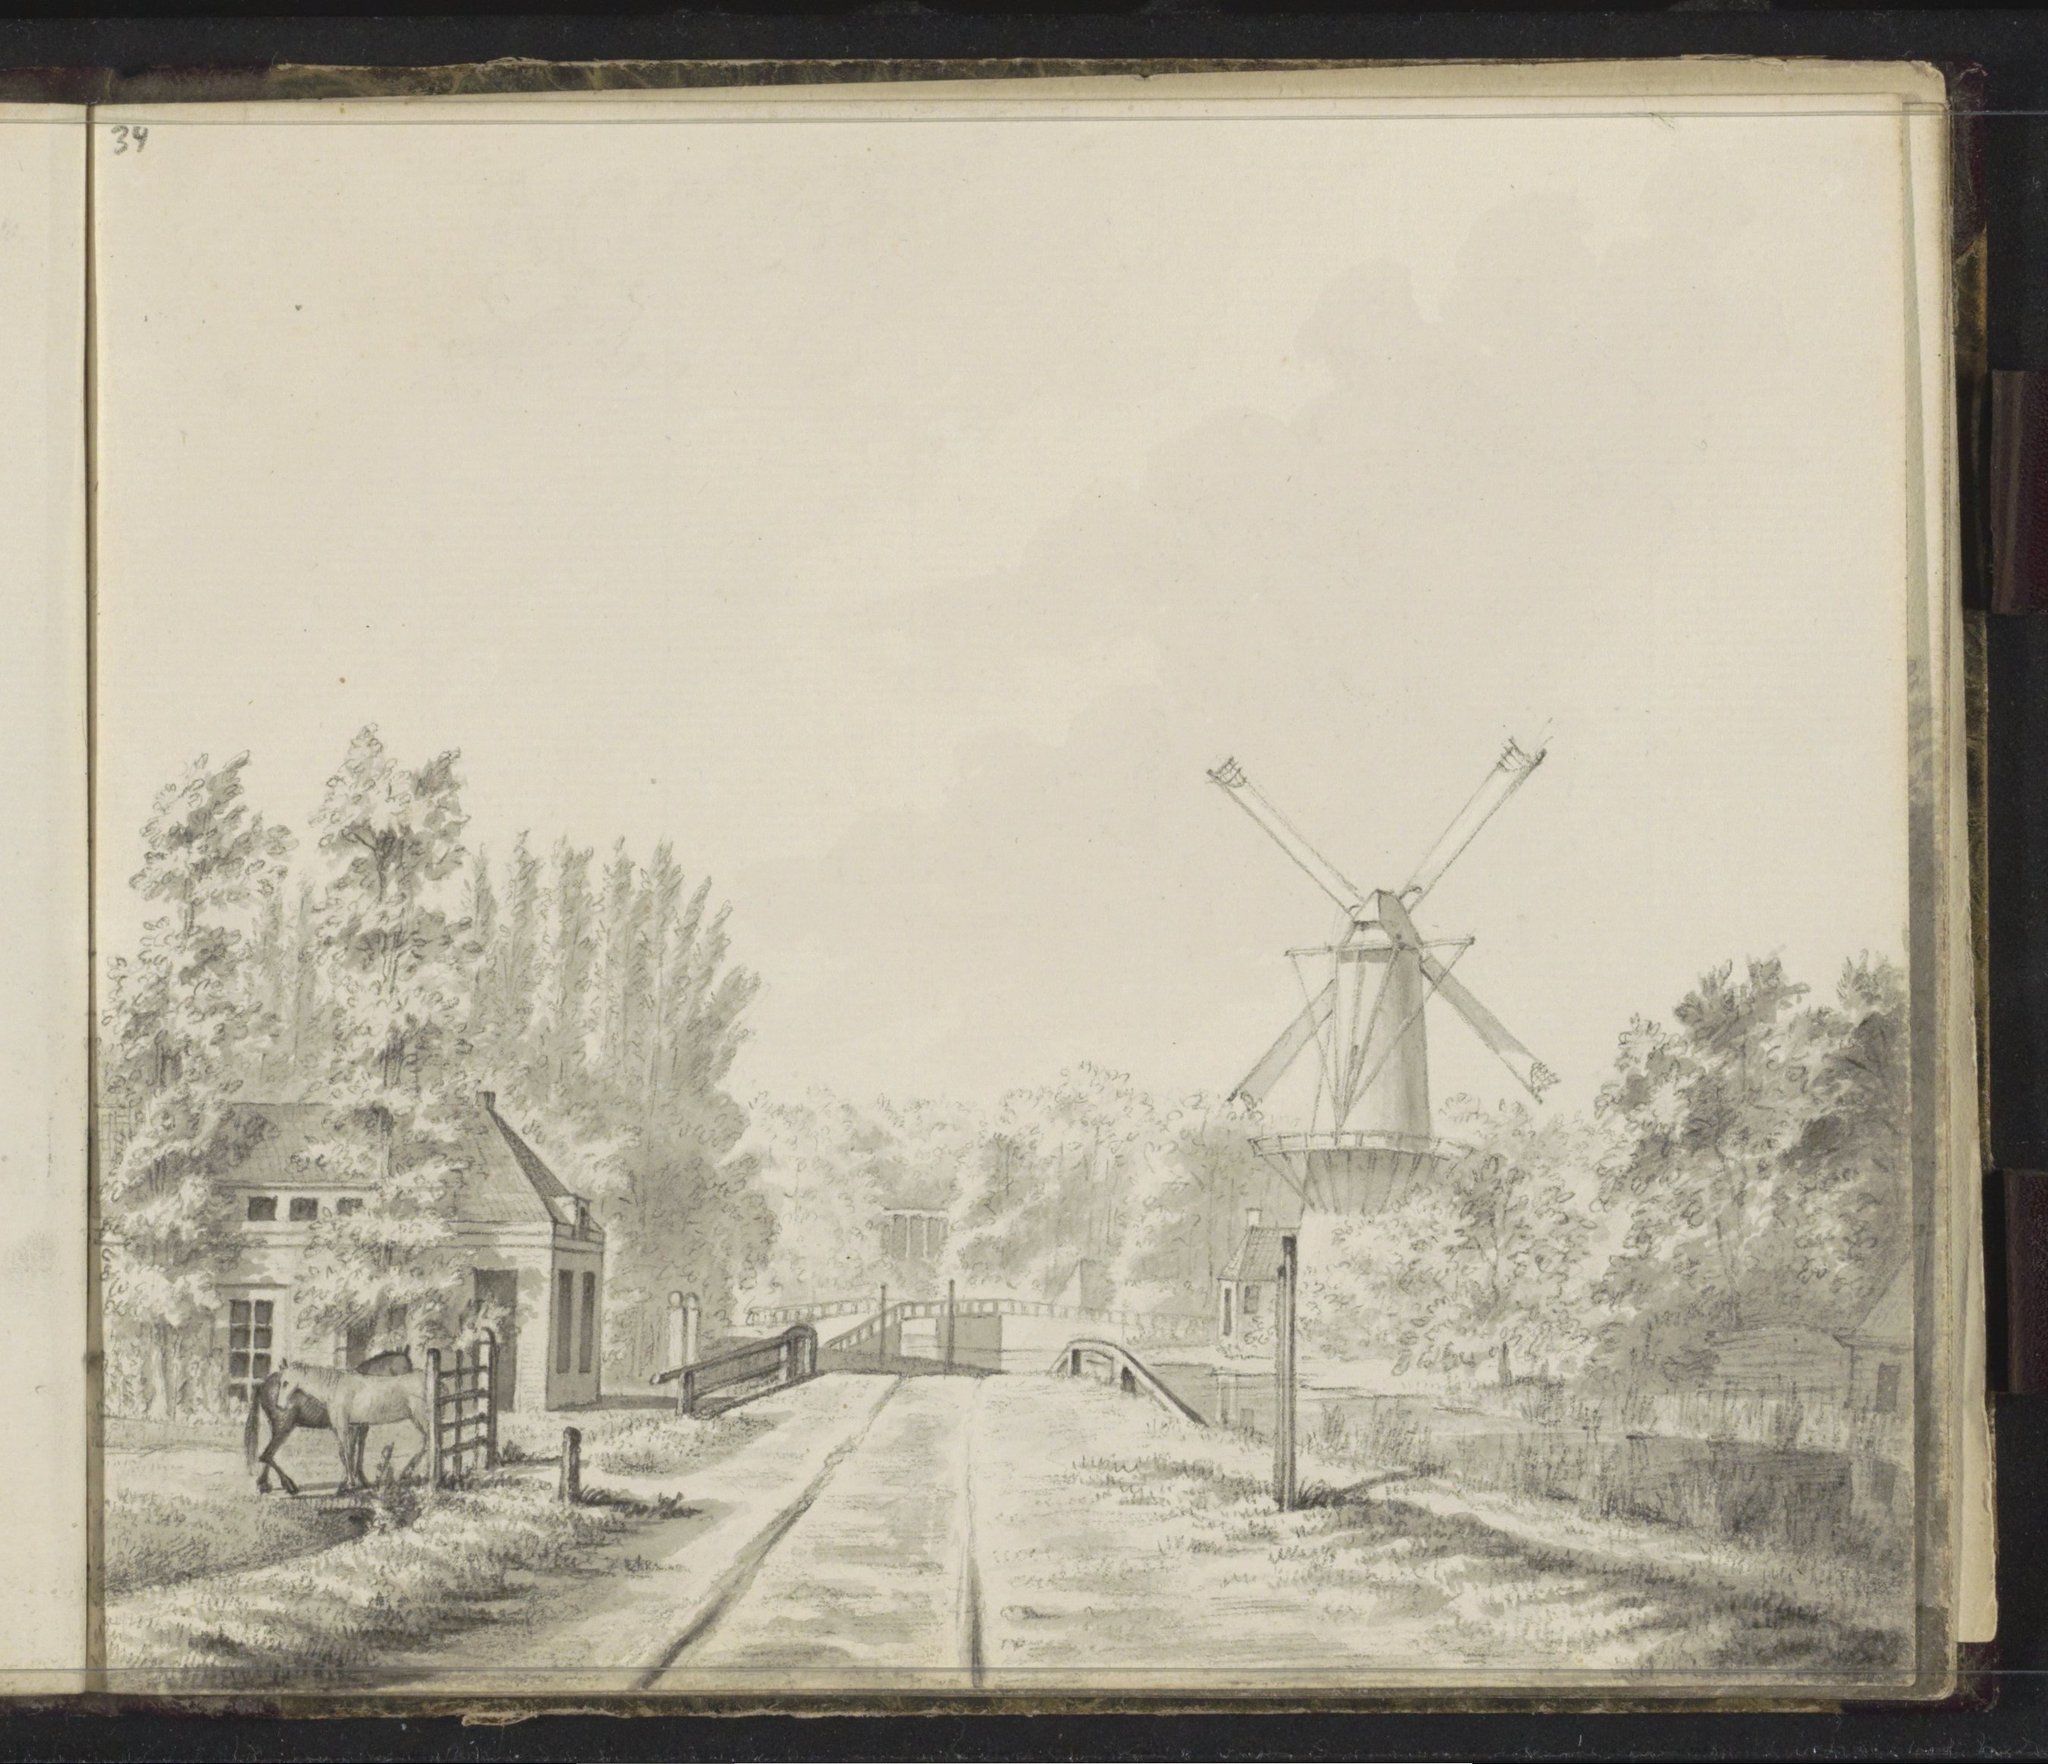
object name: sketchbook leaf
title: Molen aan een vaart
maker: hendrik abraham klinkhamer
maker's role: draughtsman, painter, print maker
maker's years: 1810-1872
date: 1820-1872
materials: chalk, paper, watercolor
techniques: brush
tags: canal, windmill in landscape, horse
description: Langs de vaart loopt een pad. In het aangrenzende weiland staan twee paarden. Blad 34 recto uit een schetsboek met 39 bladen.